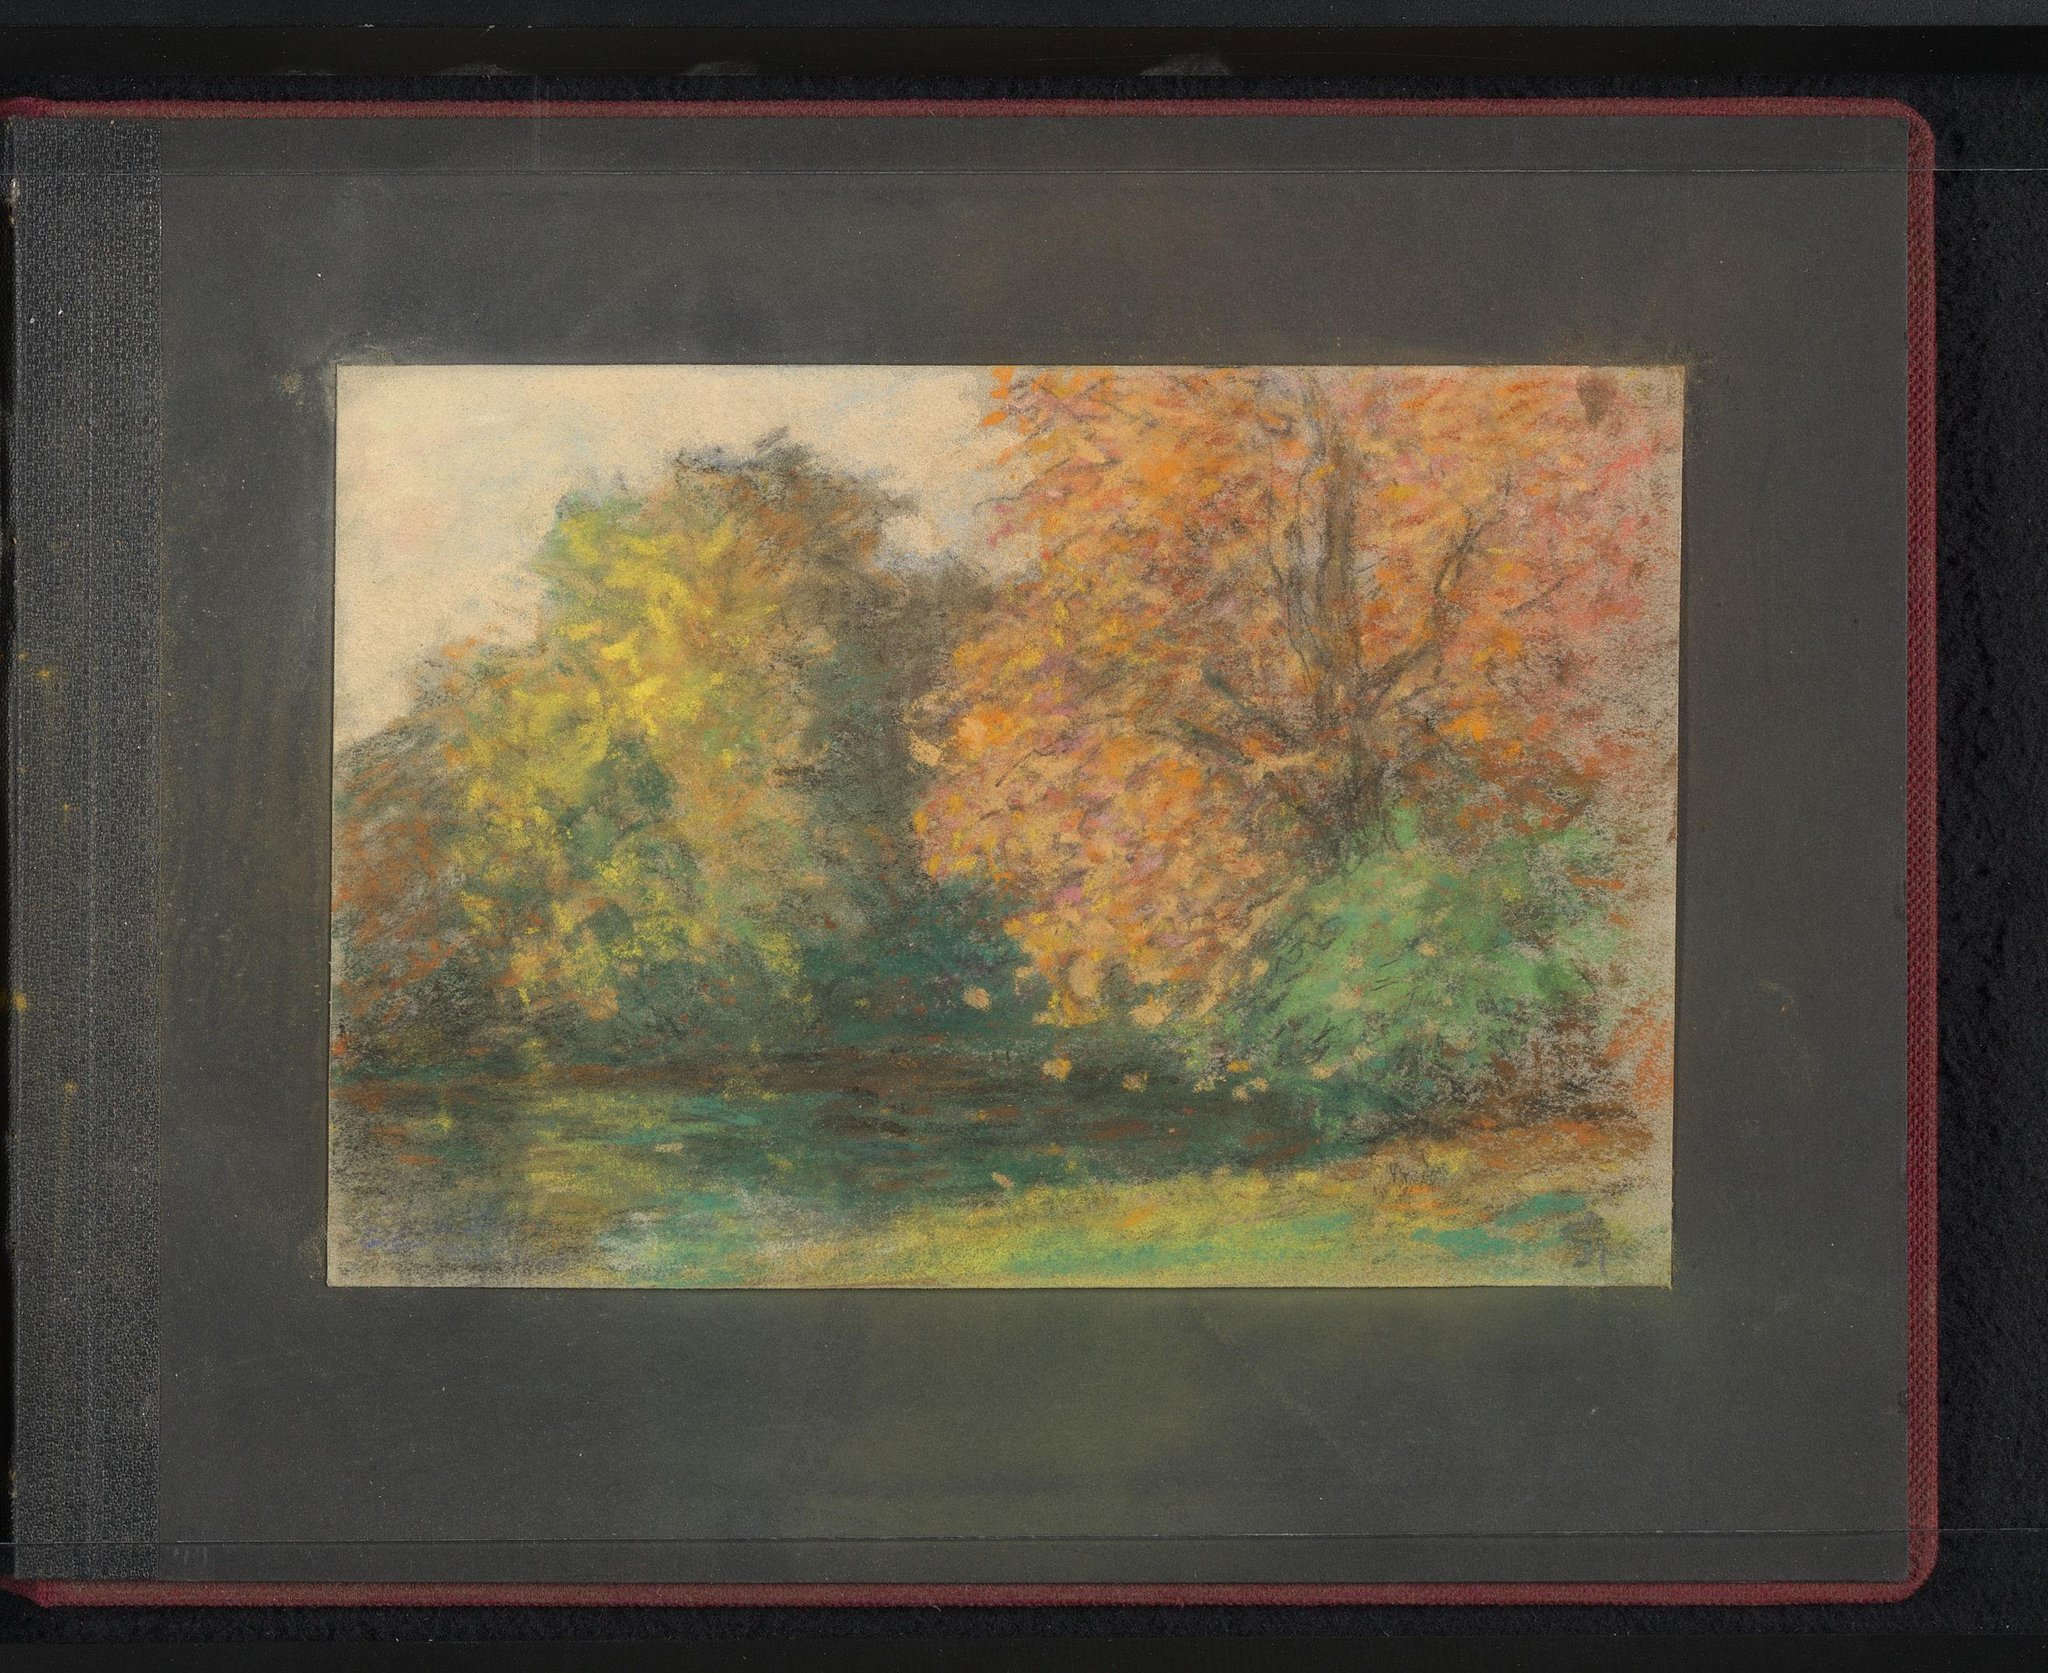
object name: drawing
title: Bomen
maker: carel nicolaas storm van s-gravesande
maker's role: draughtsman, print maker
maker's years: 1841-1924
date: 1915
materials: chalk, paper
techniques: pasting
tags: park, trees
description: Mogelijk te Wiesbaden. Tekening maakt deel uit van een album.